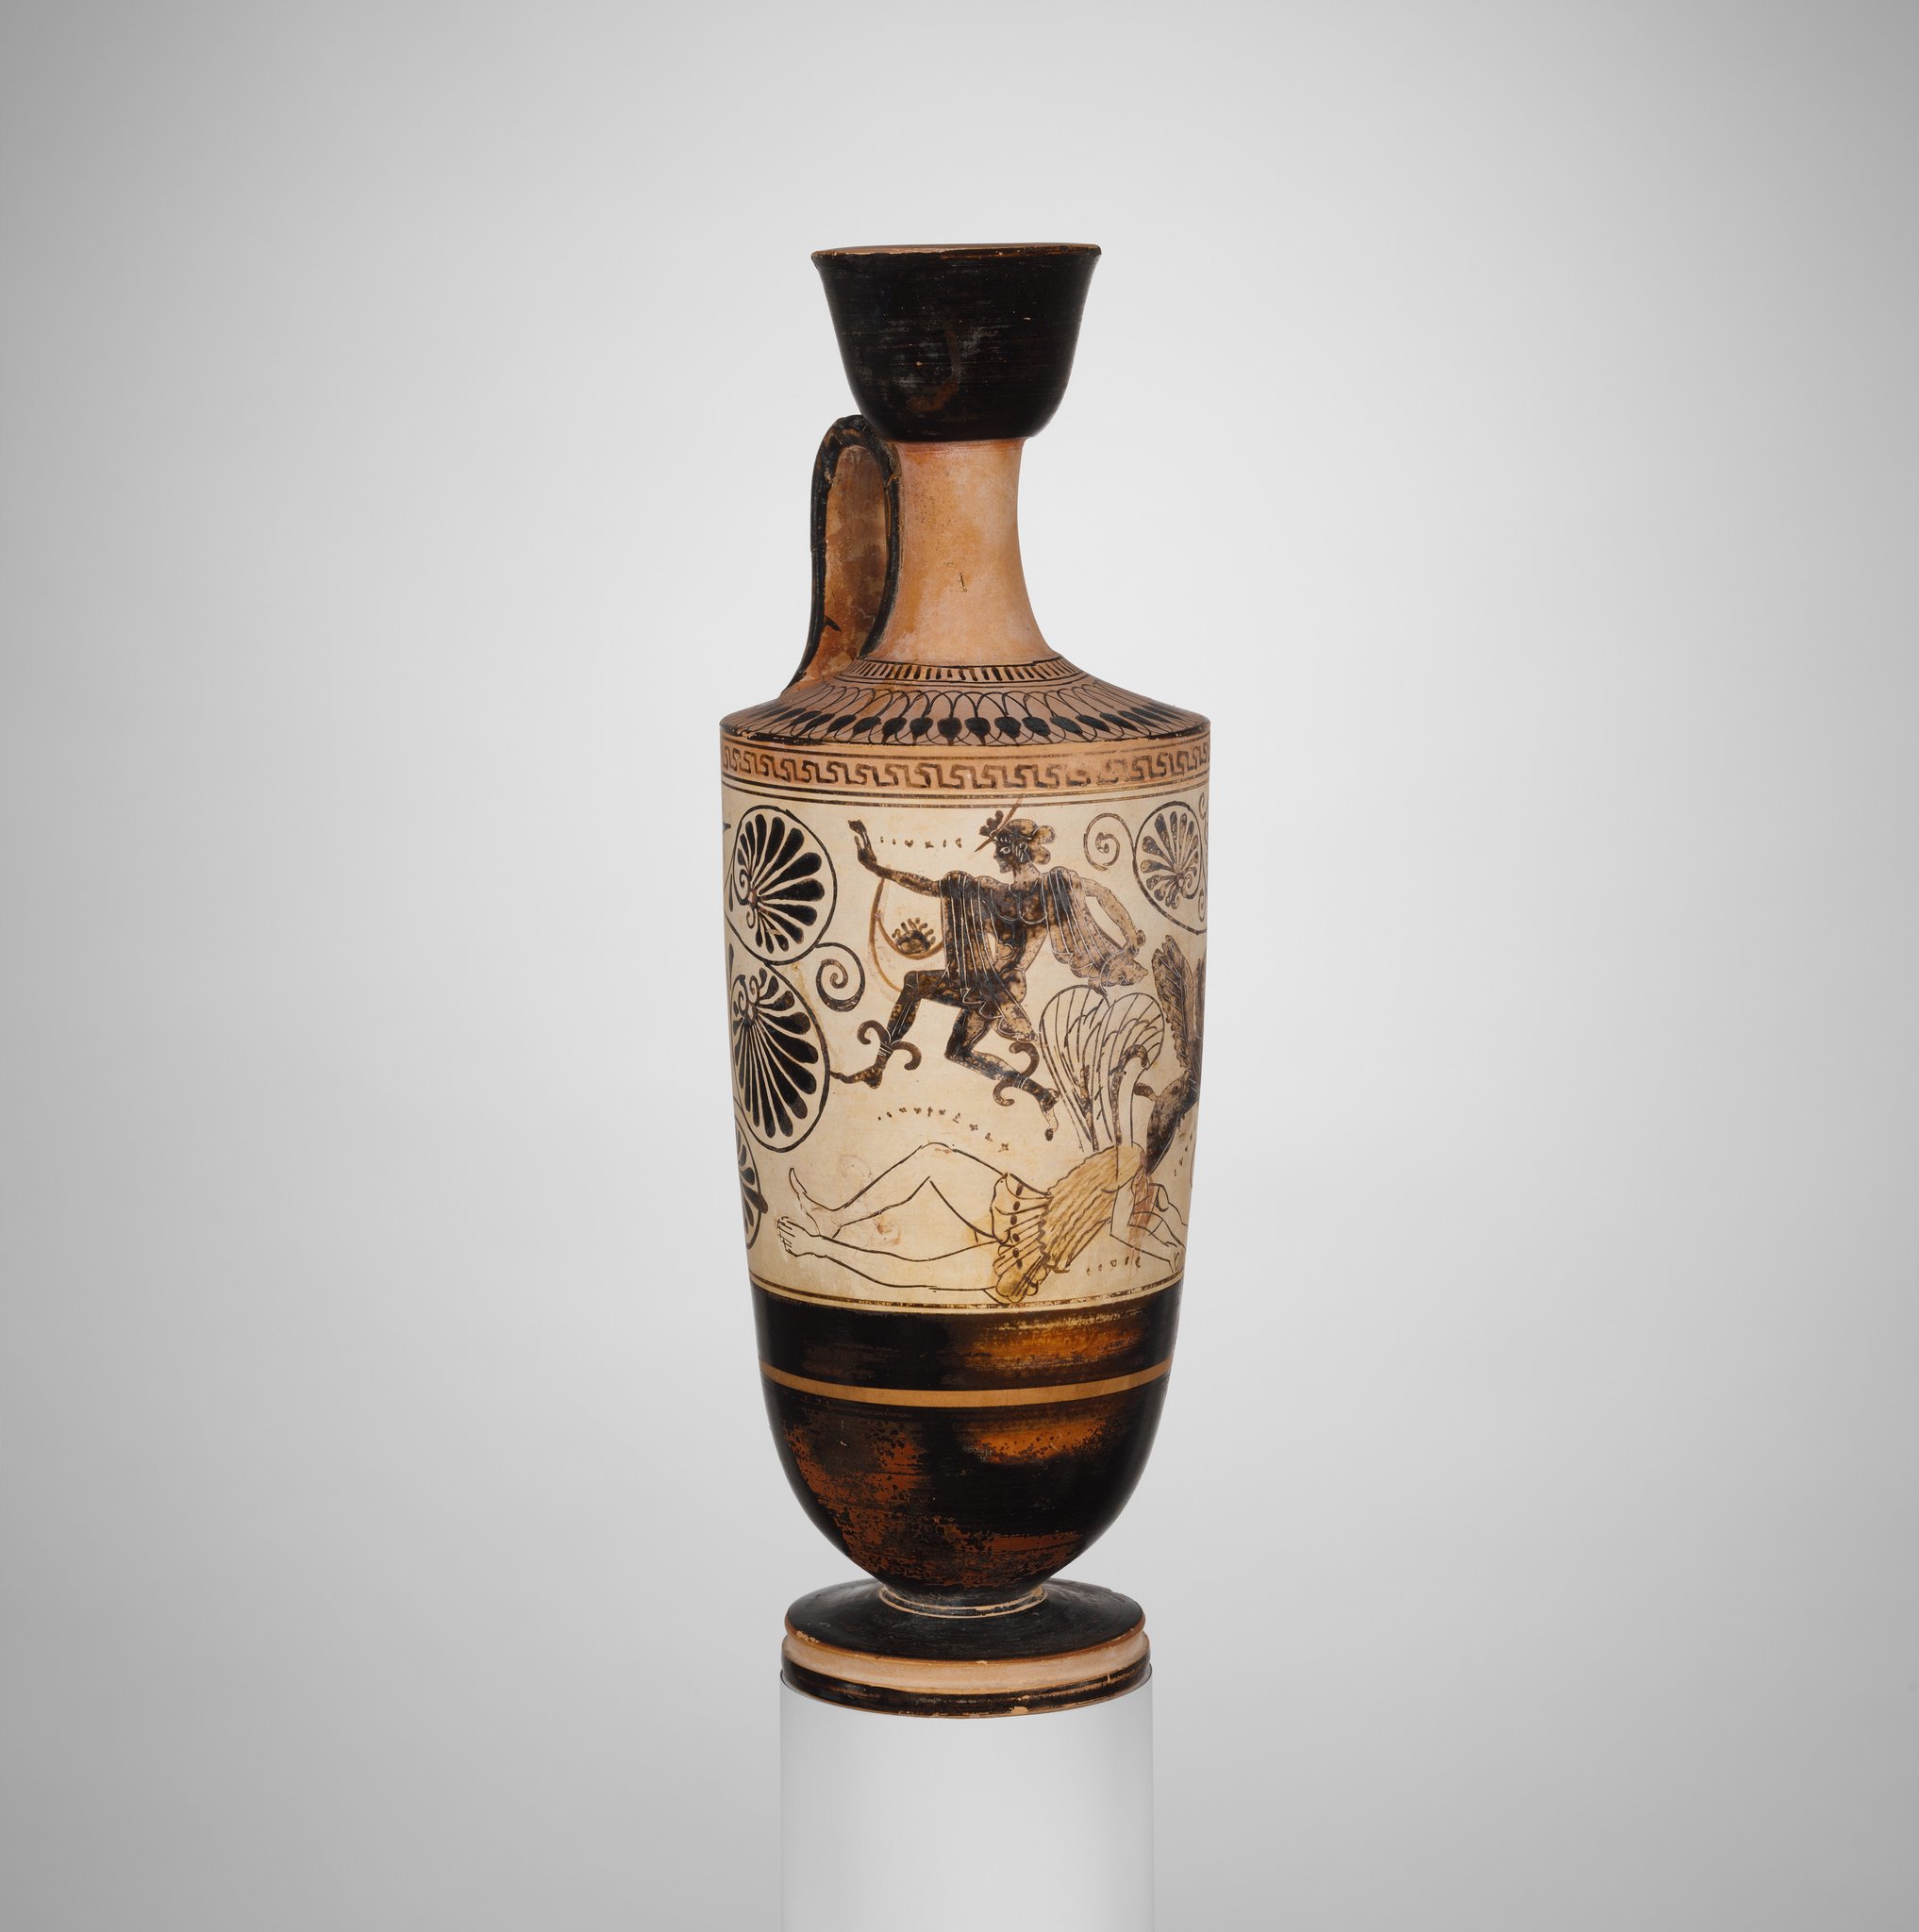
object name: lekythos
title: Terracotta lekythos (oil flask)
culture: greek, attic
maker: diosphos painter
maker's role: artist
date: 500 BCE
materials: terracotta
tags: medusa,perseus,pegasus